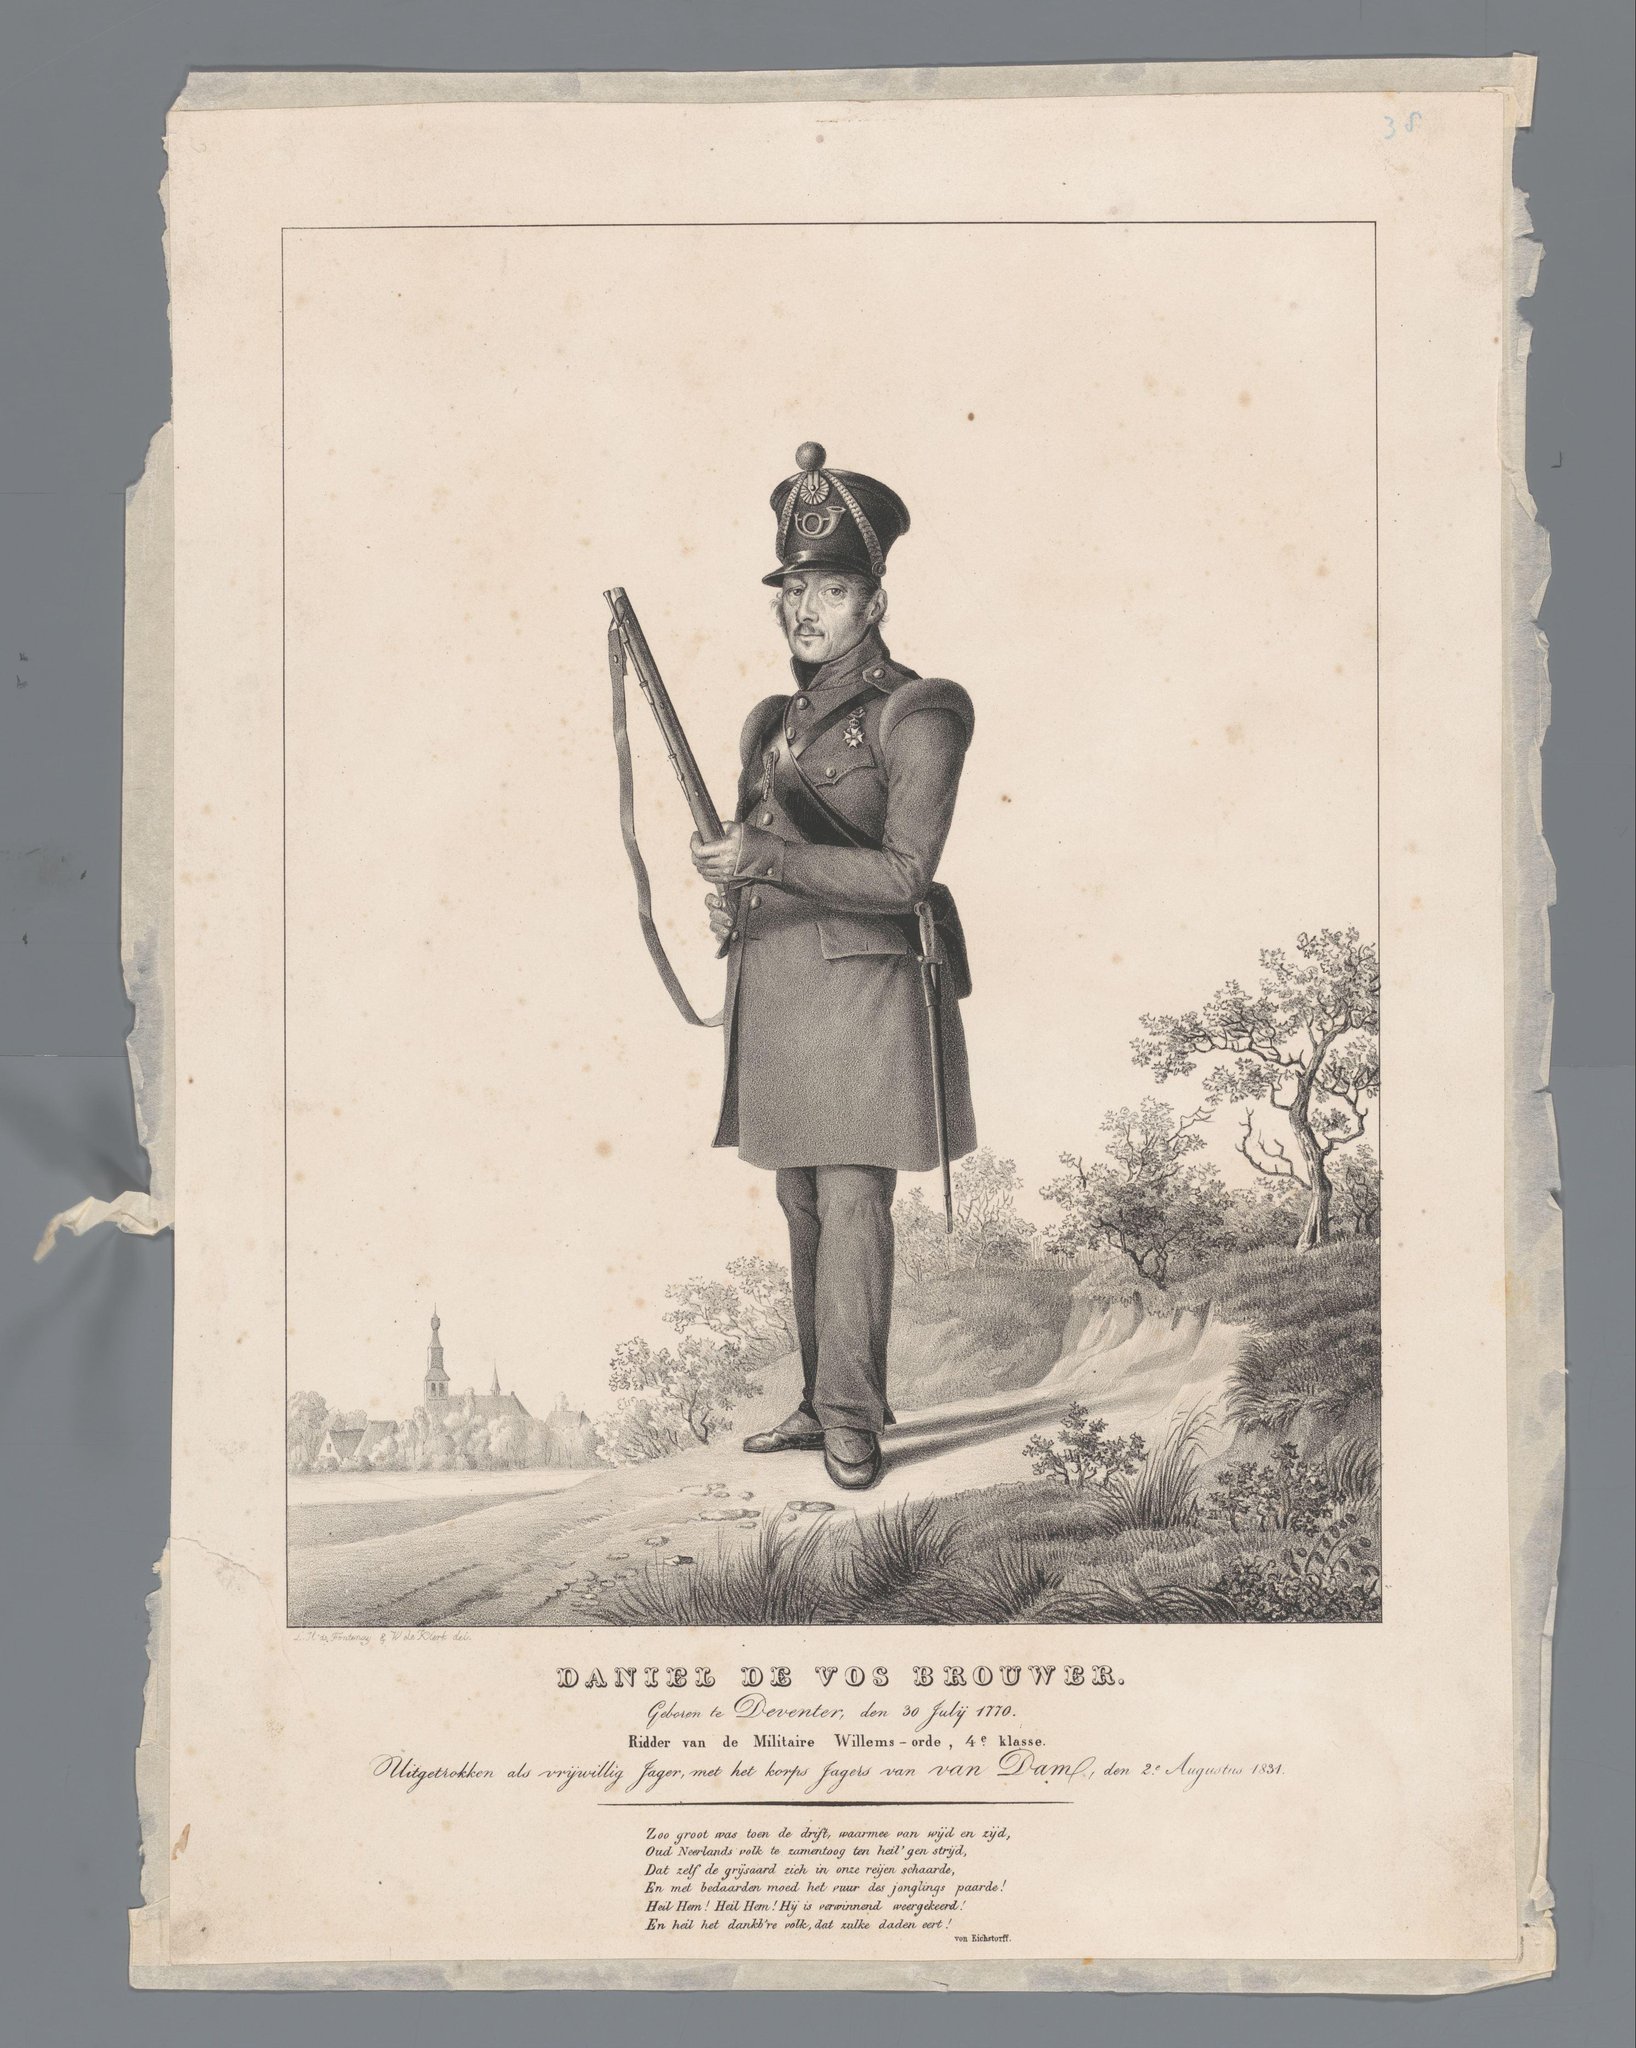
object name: print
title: Daniel de Vos Brouwer. Geboren te Deventer, den 30 Julij 1770. Ridder van de Militaire Willems-orde, 4e klasse. Uitgetrokken als vrijwillig Jager, met het korps Jagers van Van Dam, den 2e Augustus 1831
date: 1831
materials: paper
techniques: lithograph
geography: netherlands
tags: deventer, historical persons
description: Portret van Daniel de Vos Brouwer, met onderschrift en zesregelig gedicht van Eichstorff (zoo groot ... zulke daden eert!). Staande ten voeten uit, naar links, met pet waarop posthoorn en links geweer in de handen, in landschap, heuvel naar rechts met dorp links.